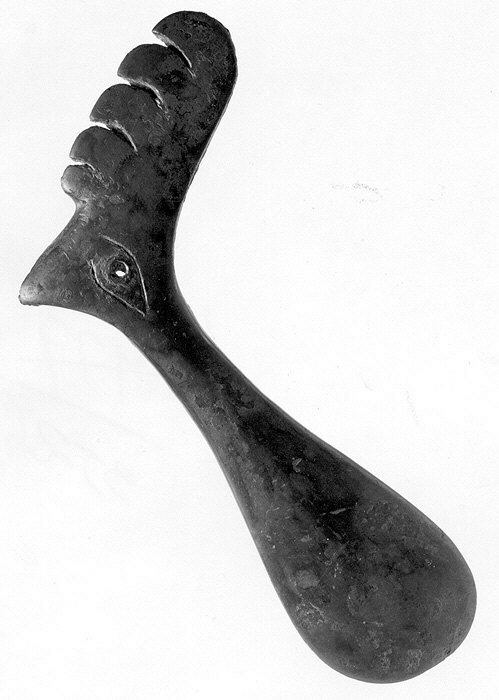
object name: axe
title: Axe with shaft hole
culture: bactria-margiana archaeological complex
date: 2333-1668 BCE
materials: copper alloy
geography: bactria-margiana